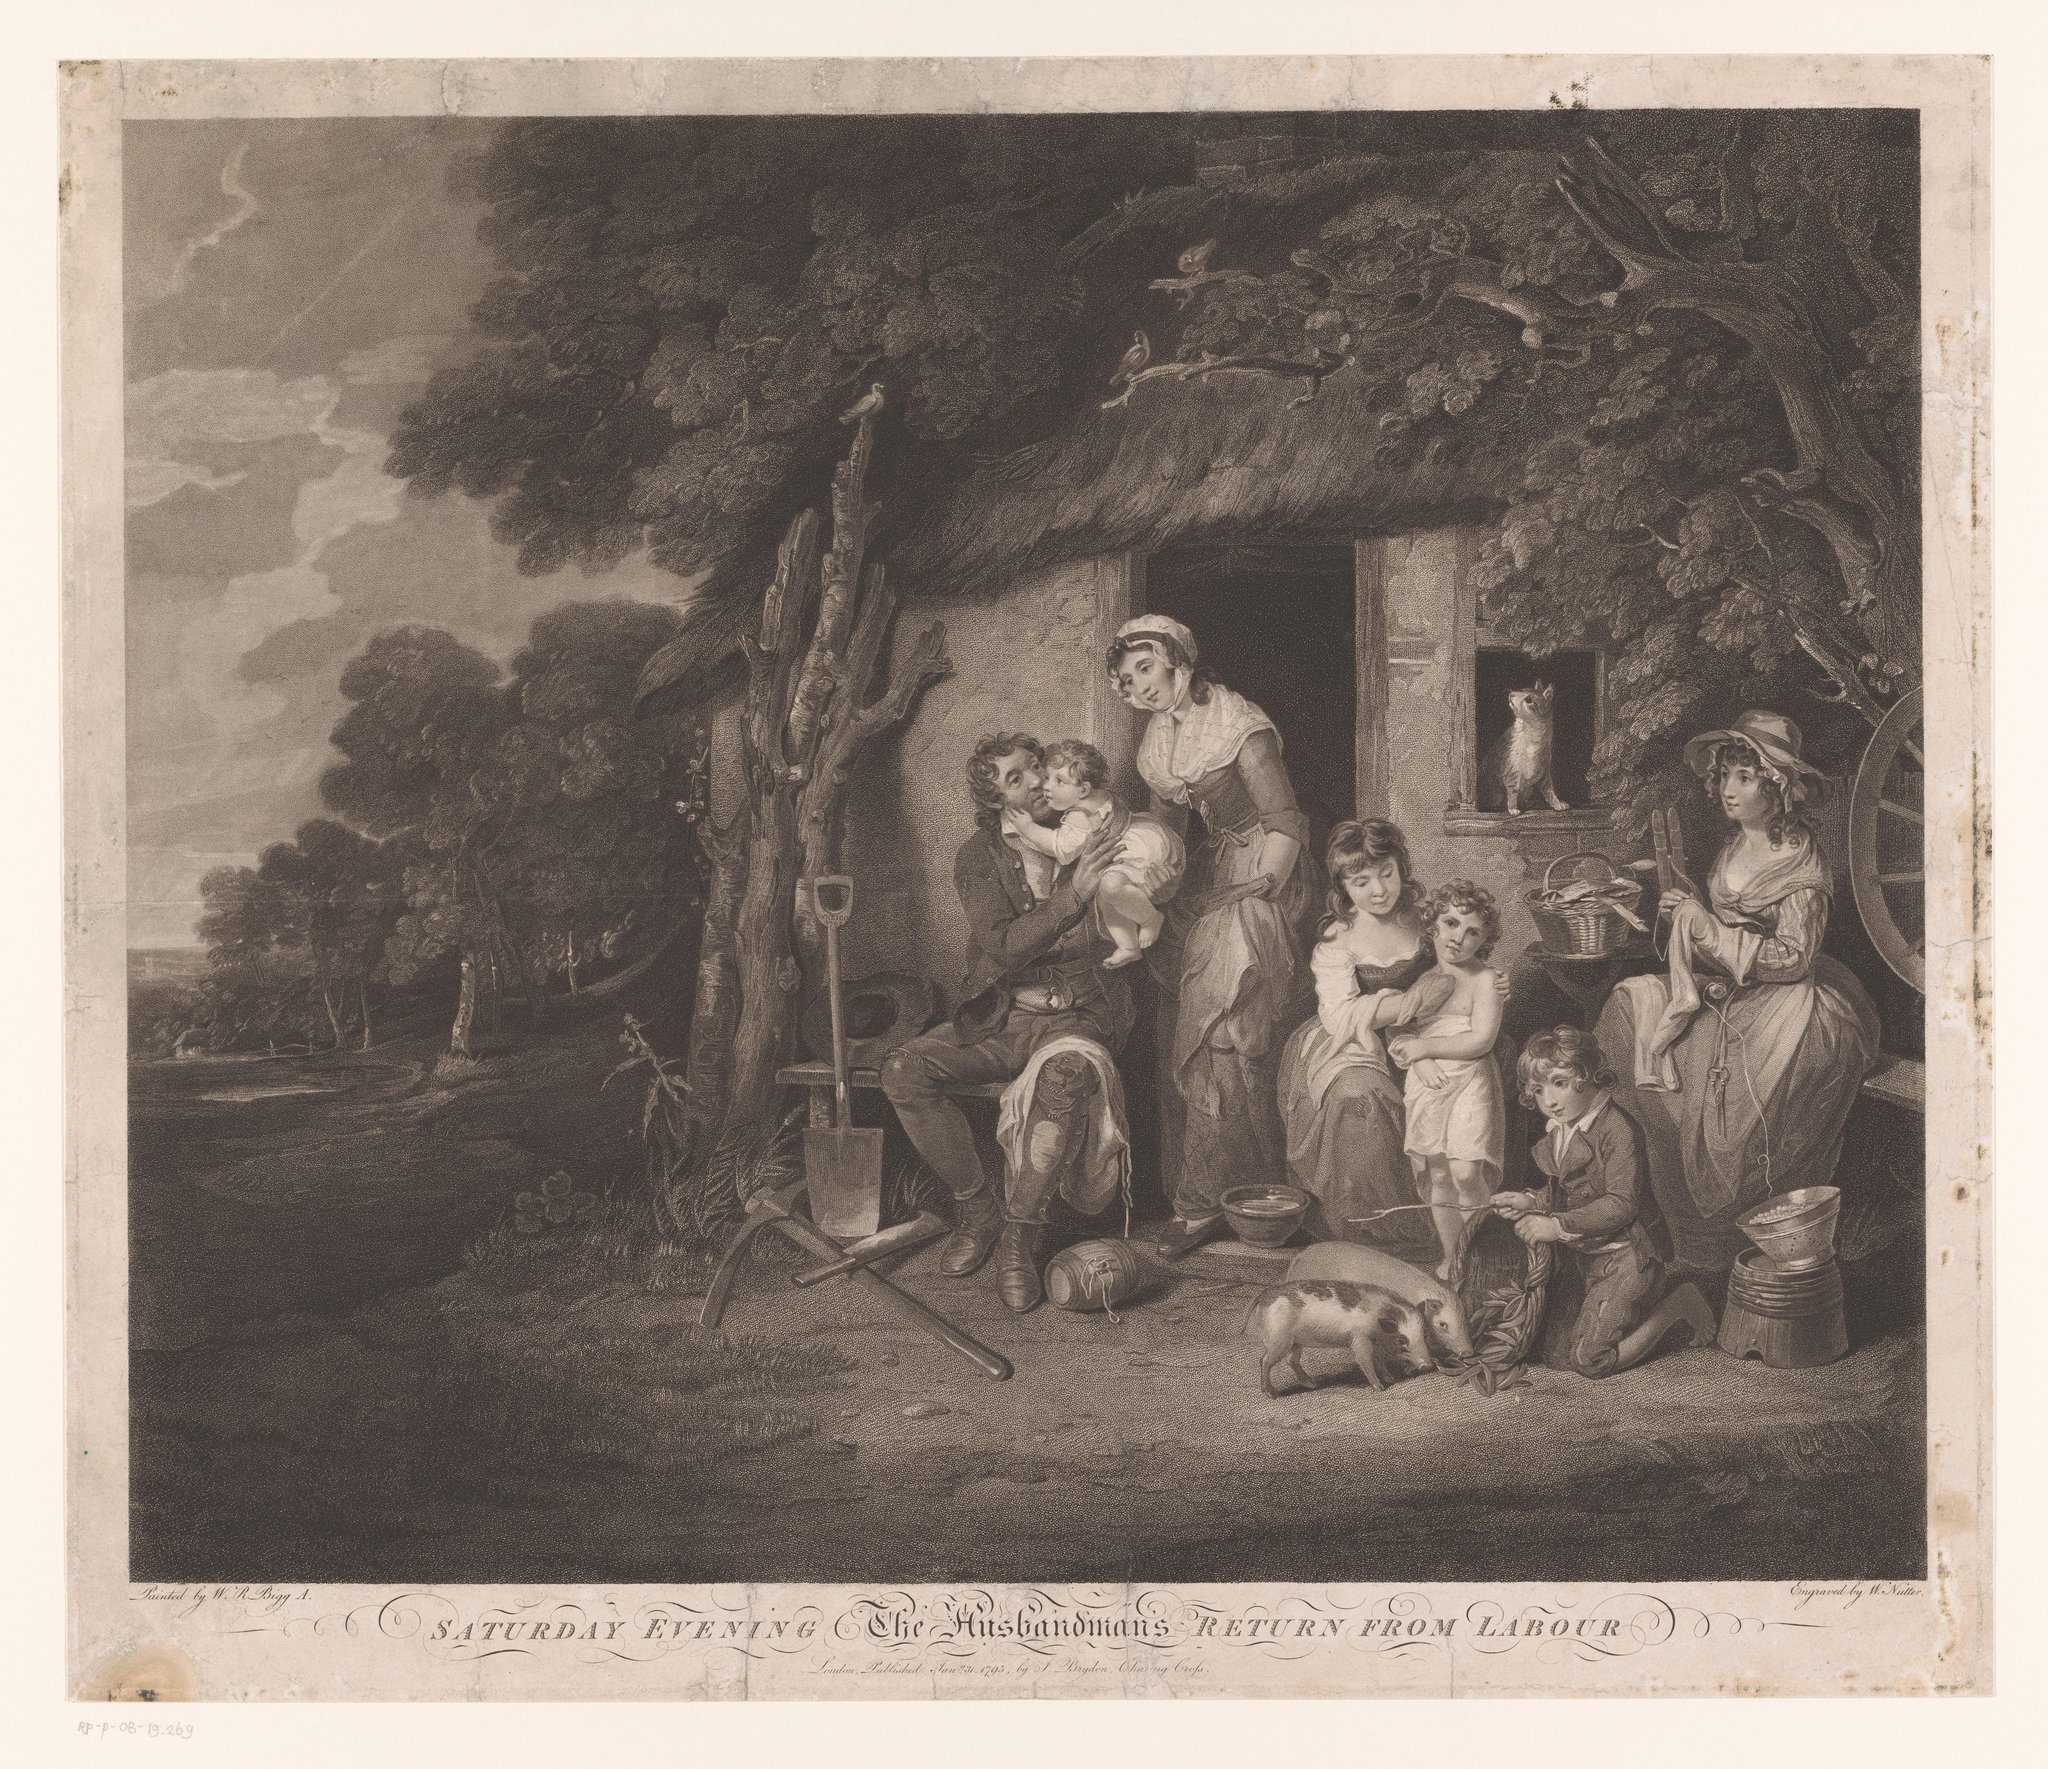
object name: print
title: Terugkeer van een vader bij zijn gezin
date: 1795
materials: paper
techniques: etching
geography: london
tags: labourers returning home, family life, arrival and return ~ travelling, sowing, washing and bathing - aa - in the open air, river (+ landscape with figures, staffage), tools, aids, implements ~ crafts and industries: pickaxe